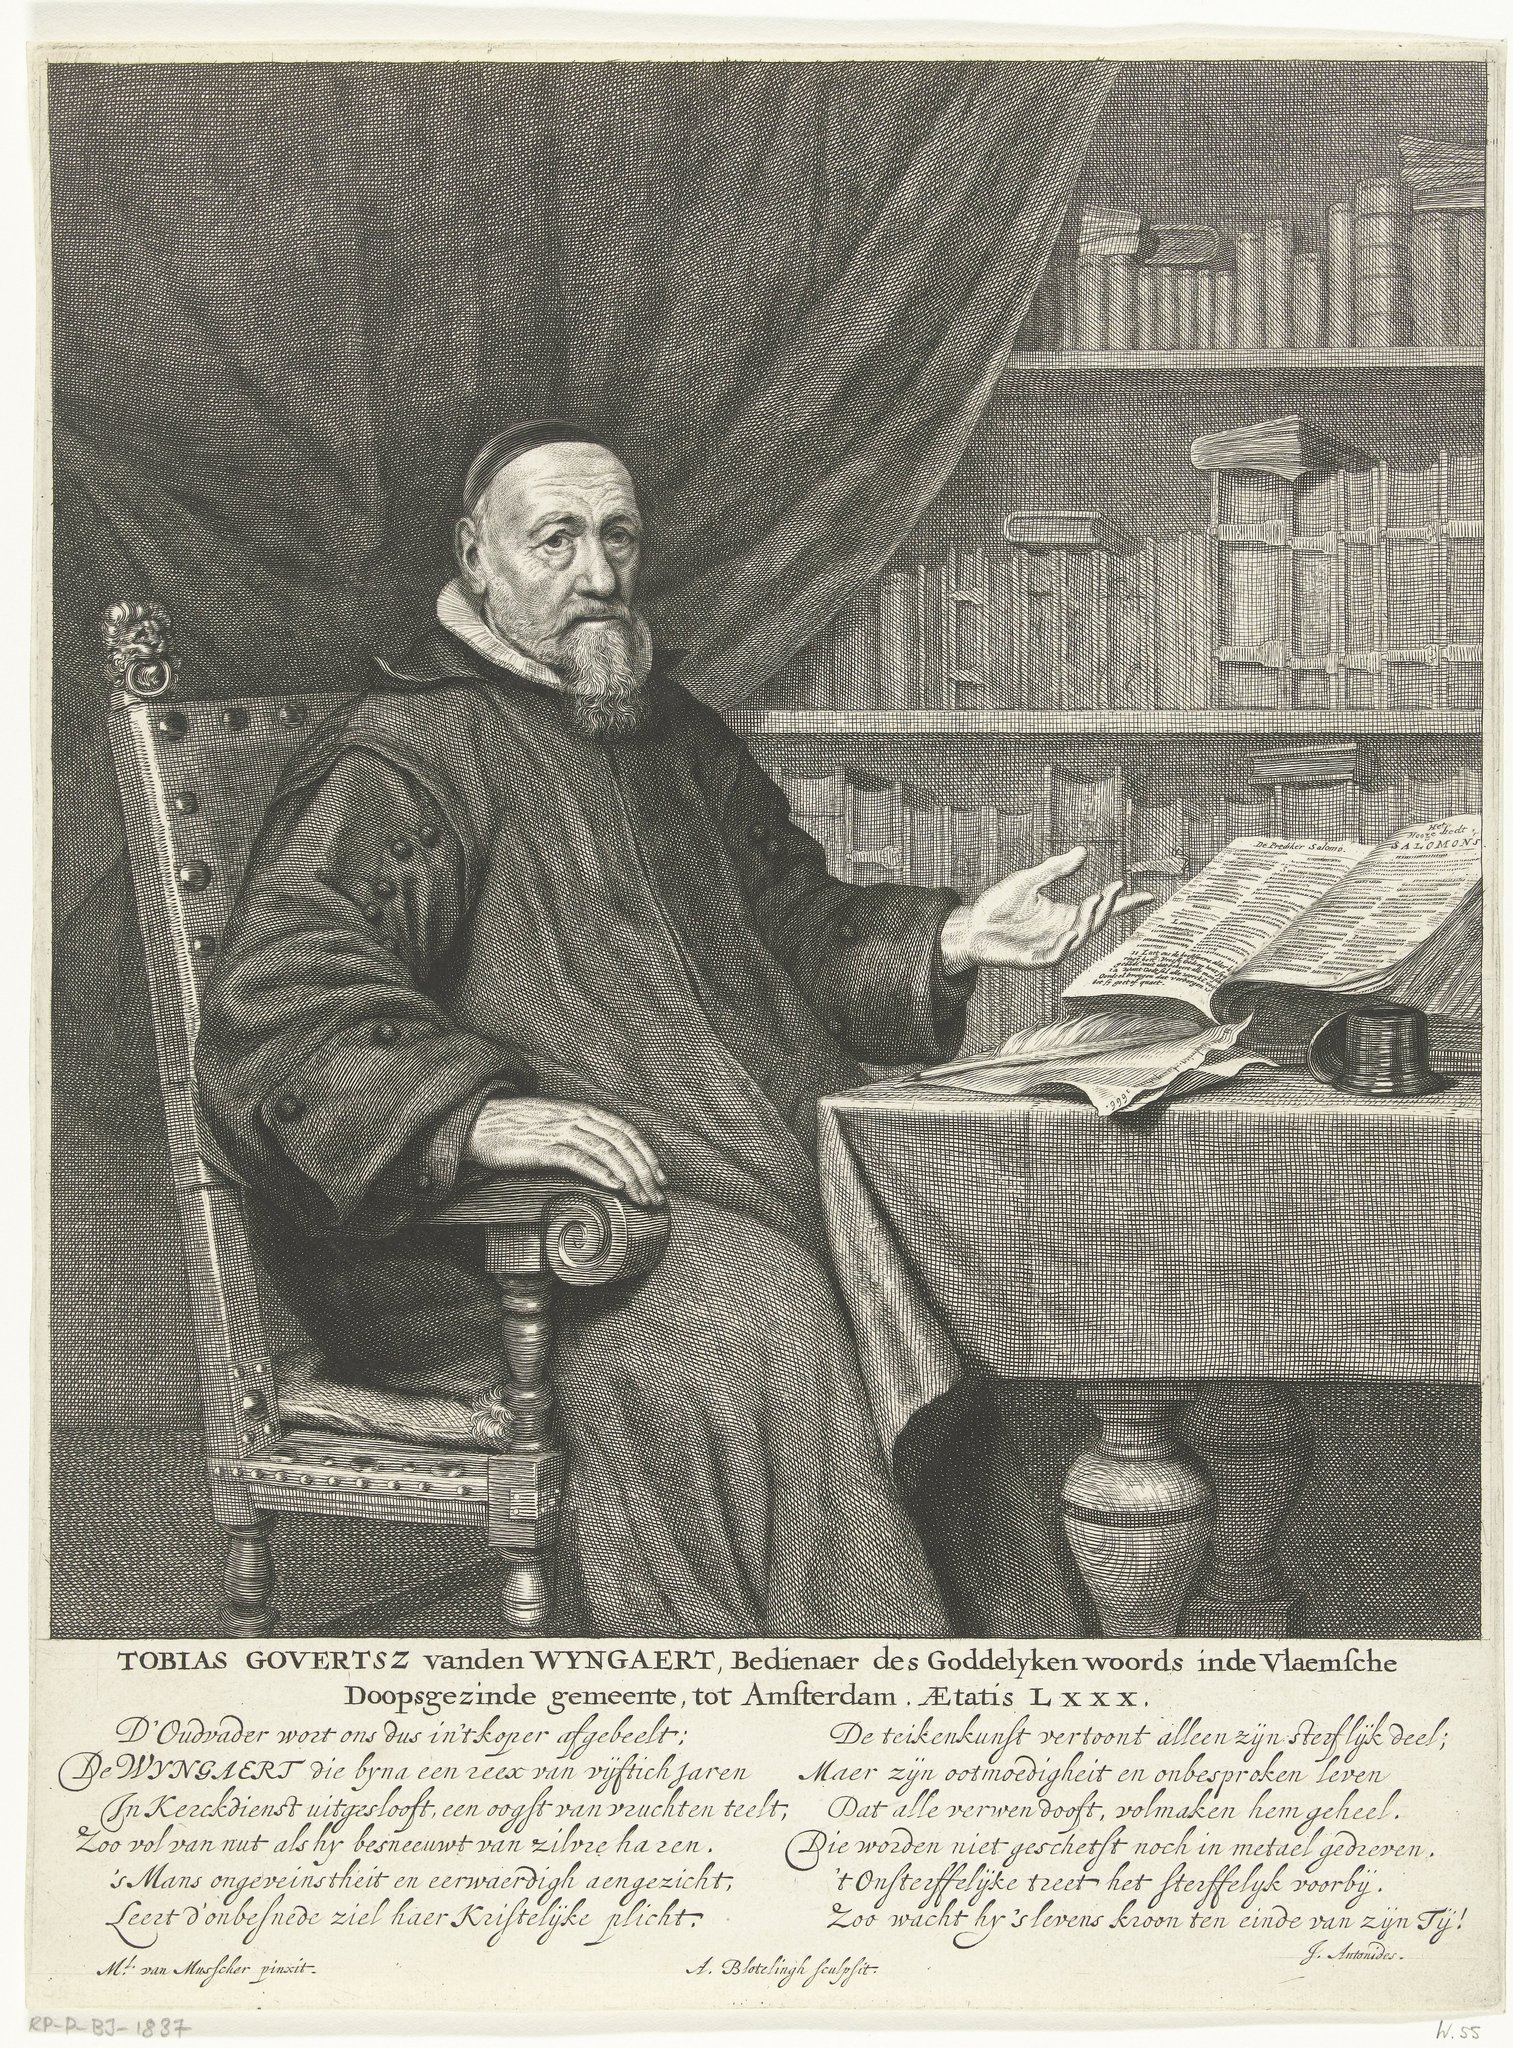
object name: print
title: Tobias Govertsz vanden Wyngaert (...)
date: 1667-1684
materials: paper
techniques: engraving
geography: amsterdam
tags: amsterdam, tobias govertsz. van den wyngaert, scholar in his study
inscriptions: collector's mark: Lugt 2228, collector's mark: Lugt 240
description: Portret van de doopsgezinde predikant Tobias Govertsz. van den Wyngaert. Van den Wyngaert zit in een studievertrek aan een tafel met een opengeslagen bijbel en wijst naar een bijbelvers over de koning Salomon. Onder het portret een vers in het Nederlands over het portret.